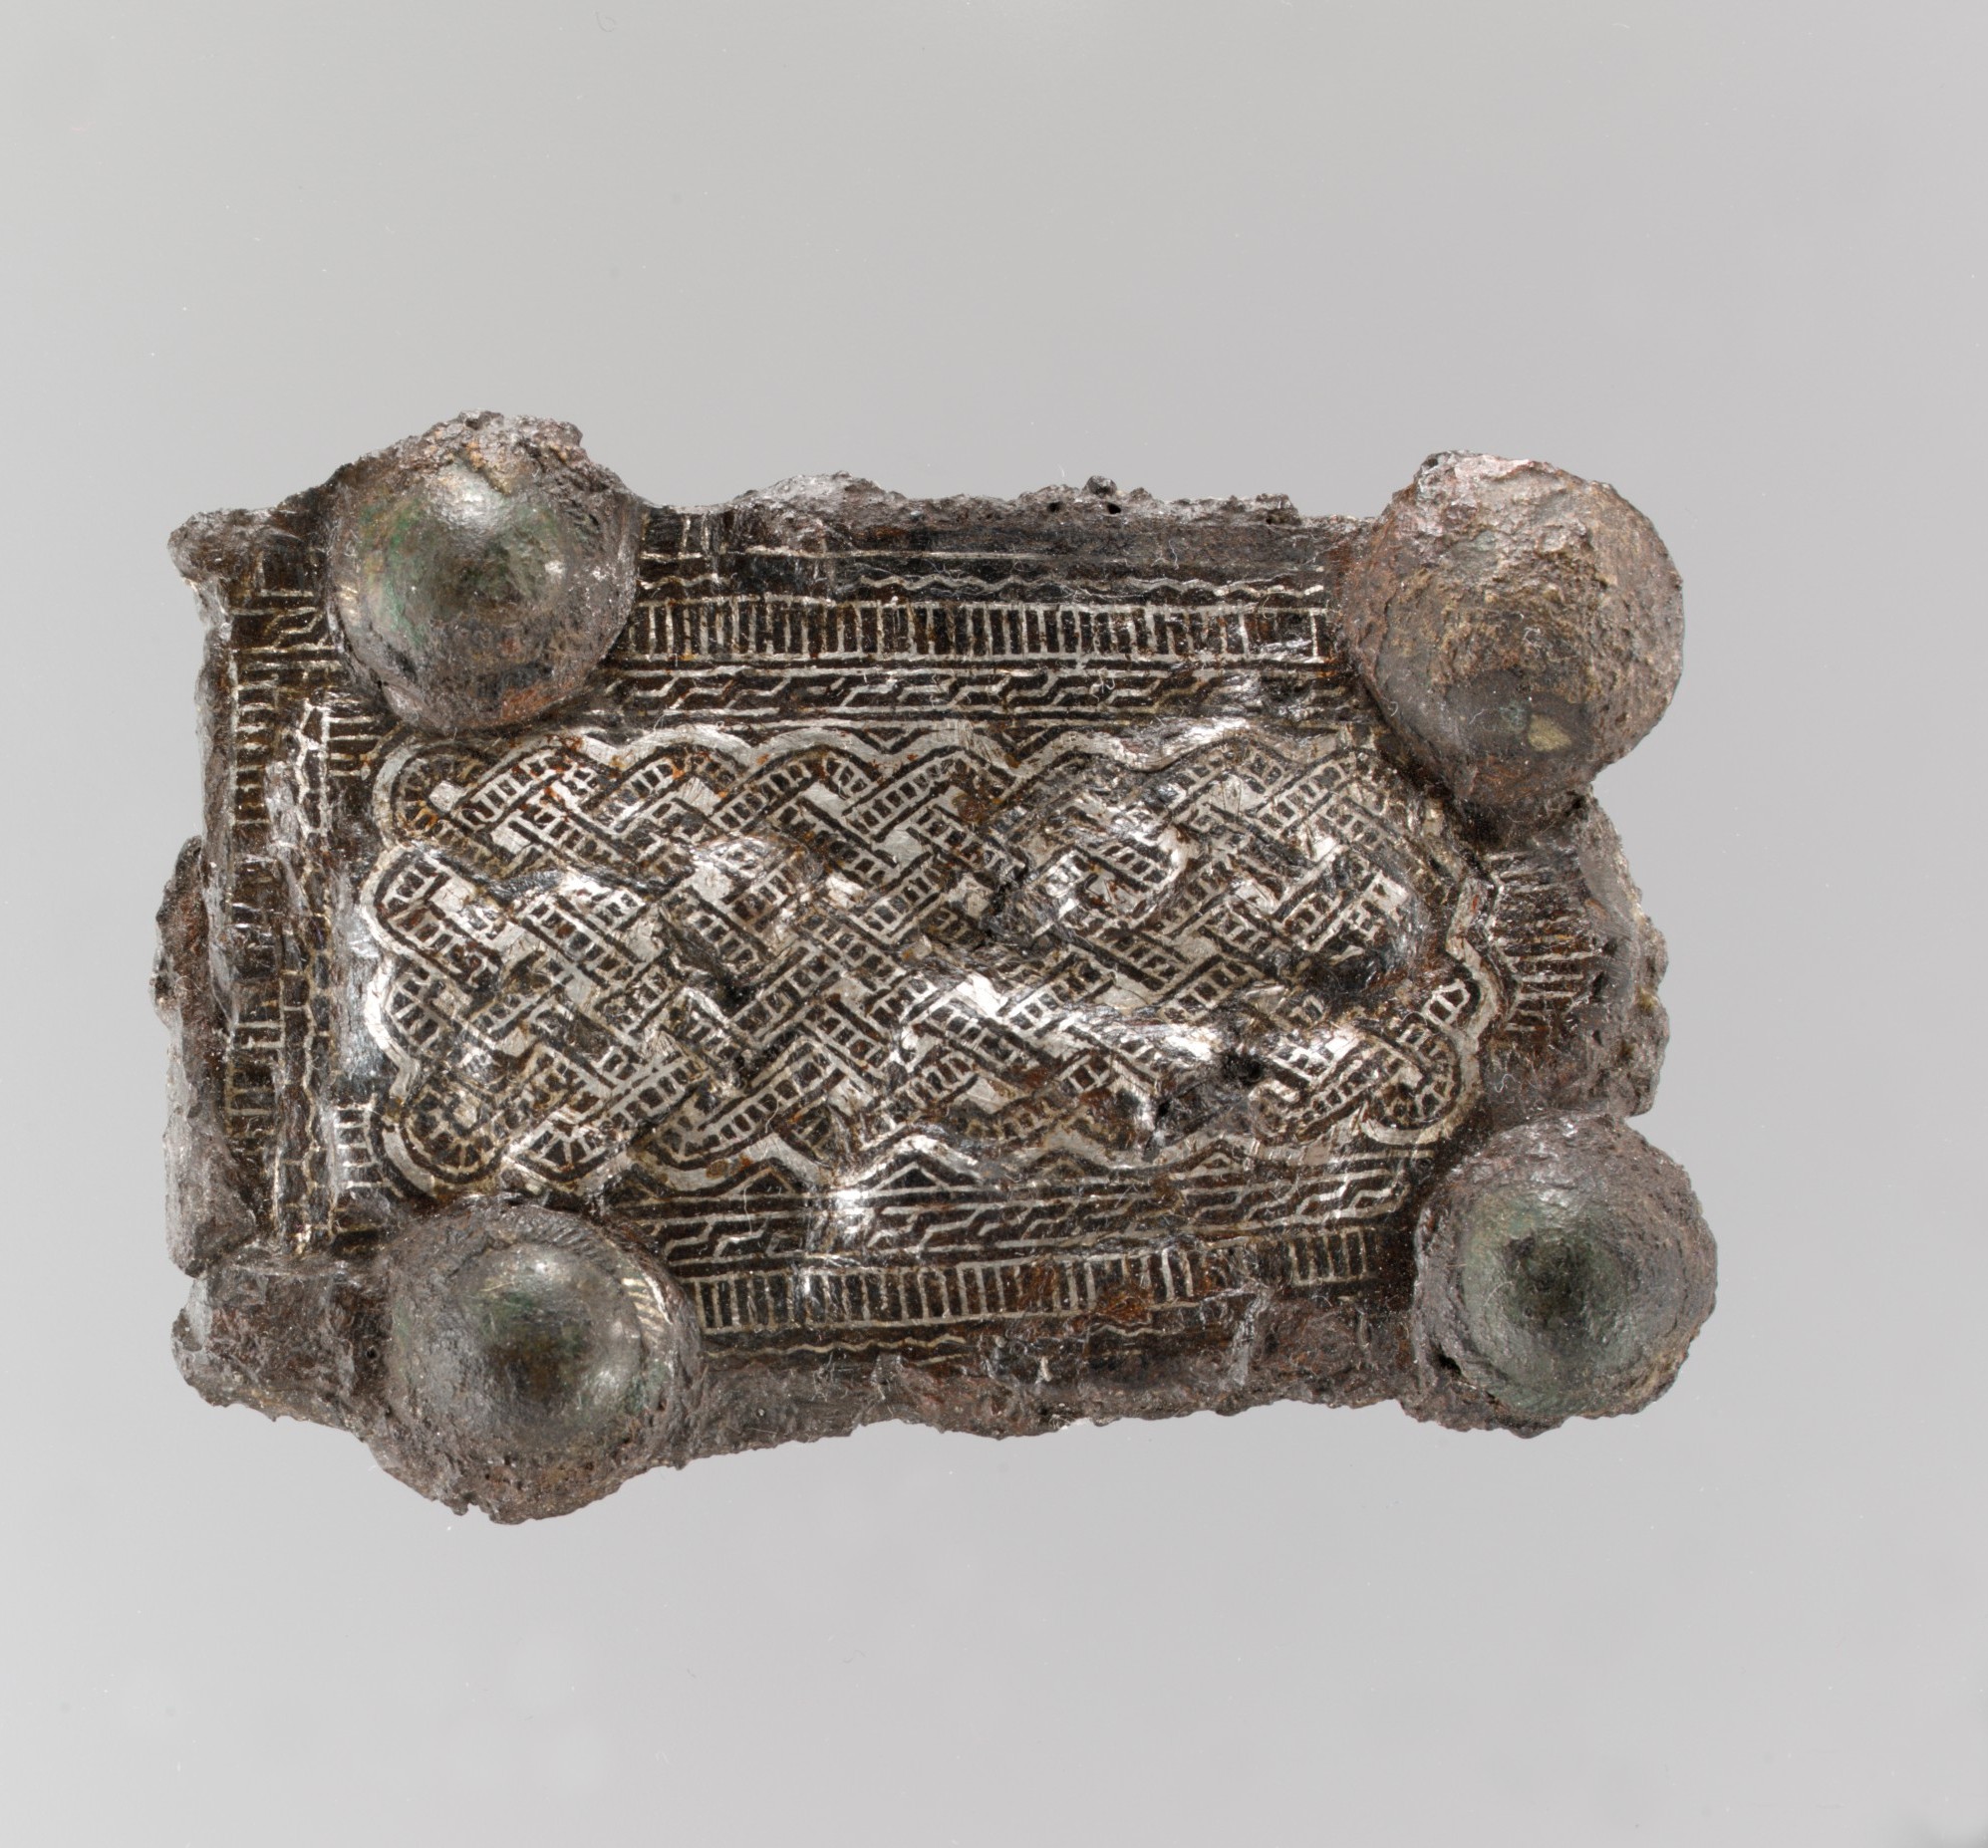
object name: belt plate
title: Counter Plate of a Belt Buckle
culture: burgundian or frankish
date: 301-700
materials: copper alloy, iron, silver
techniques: incising, inlay